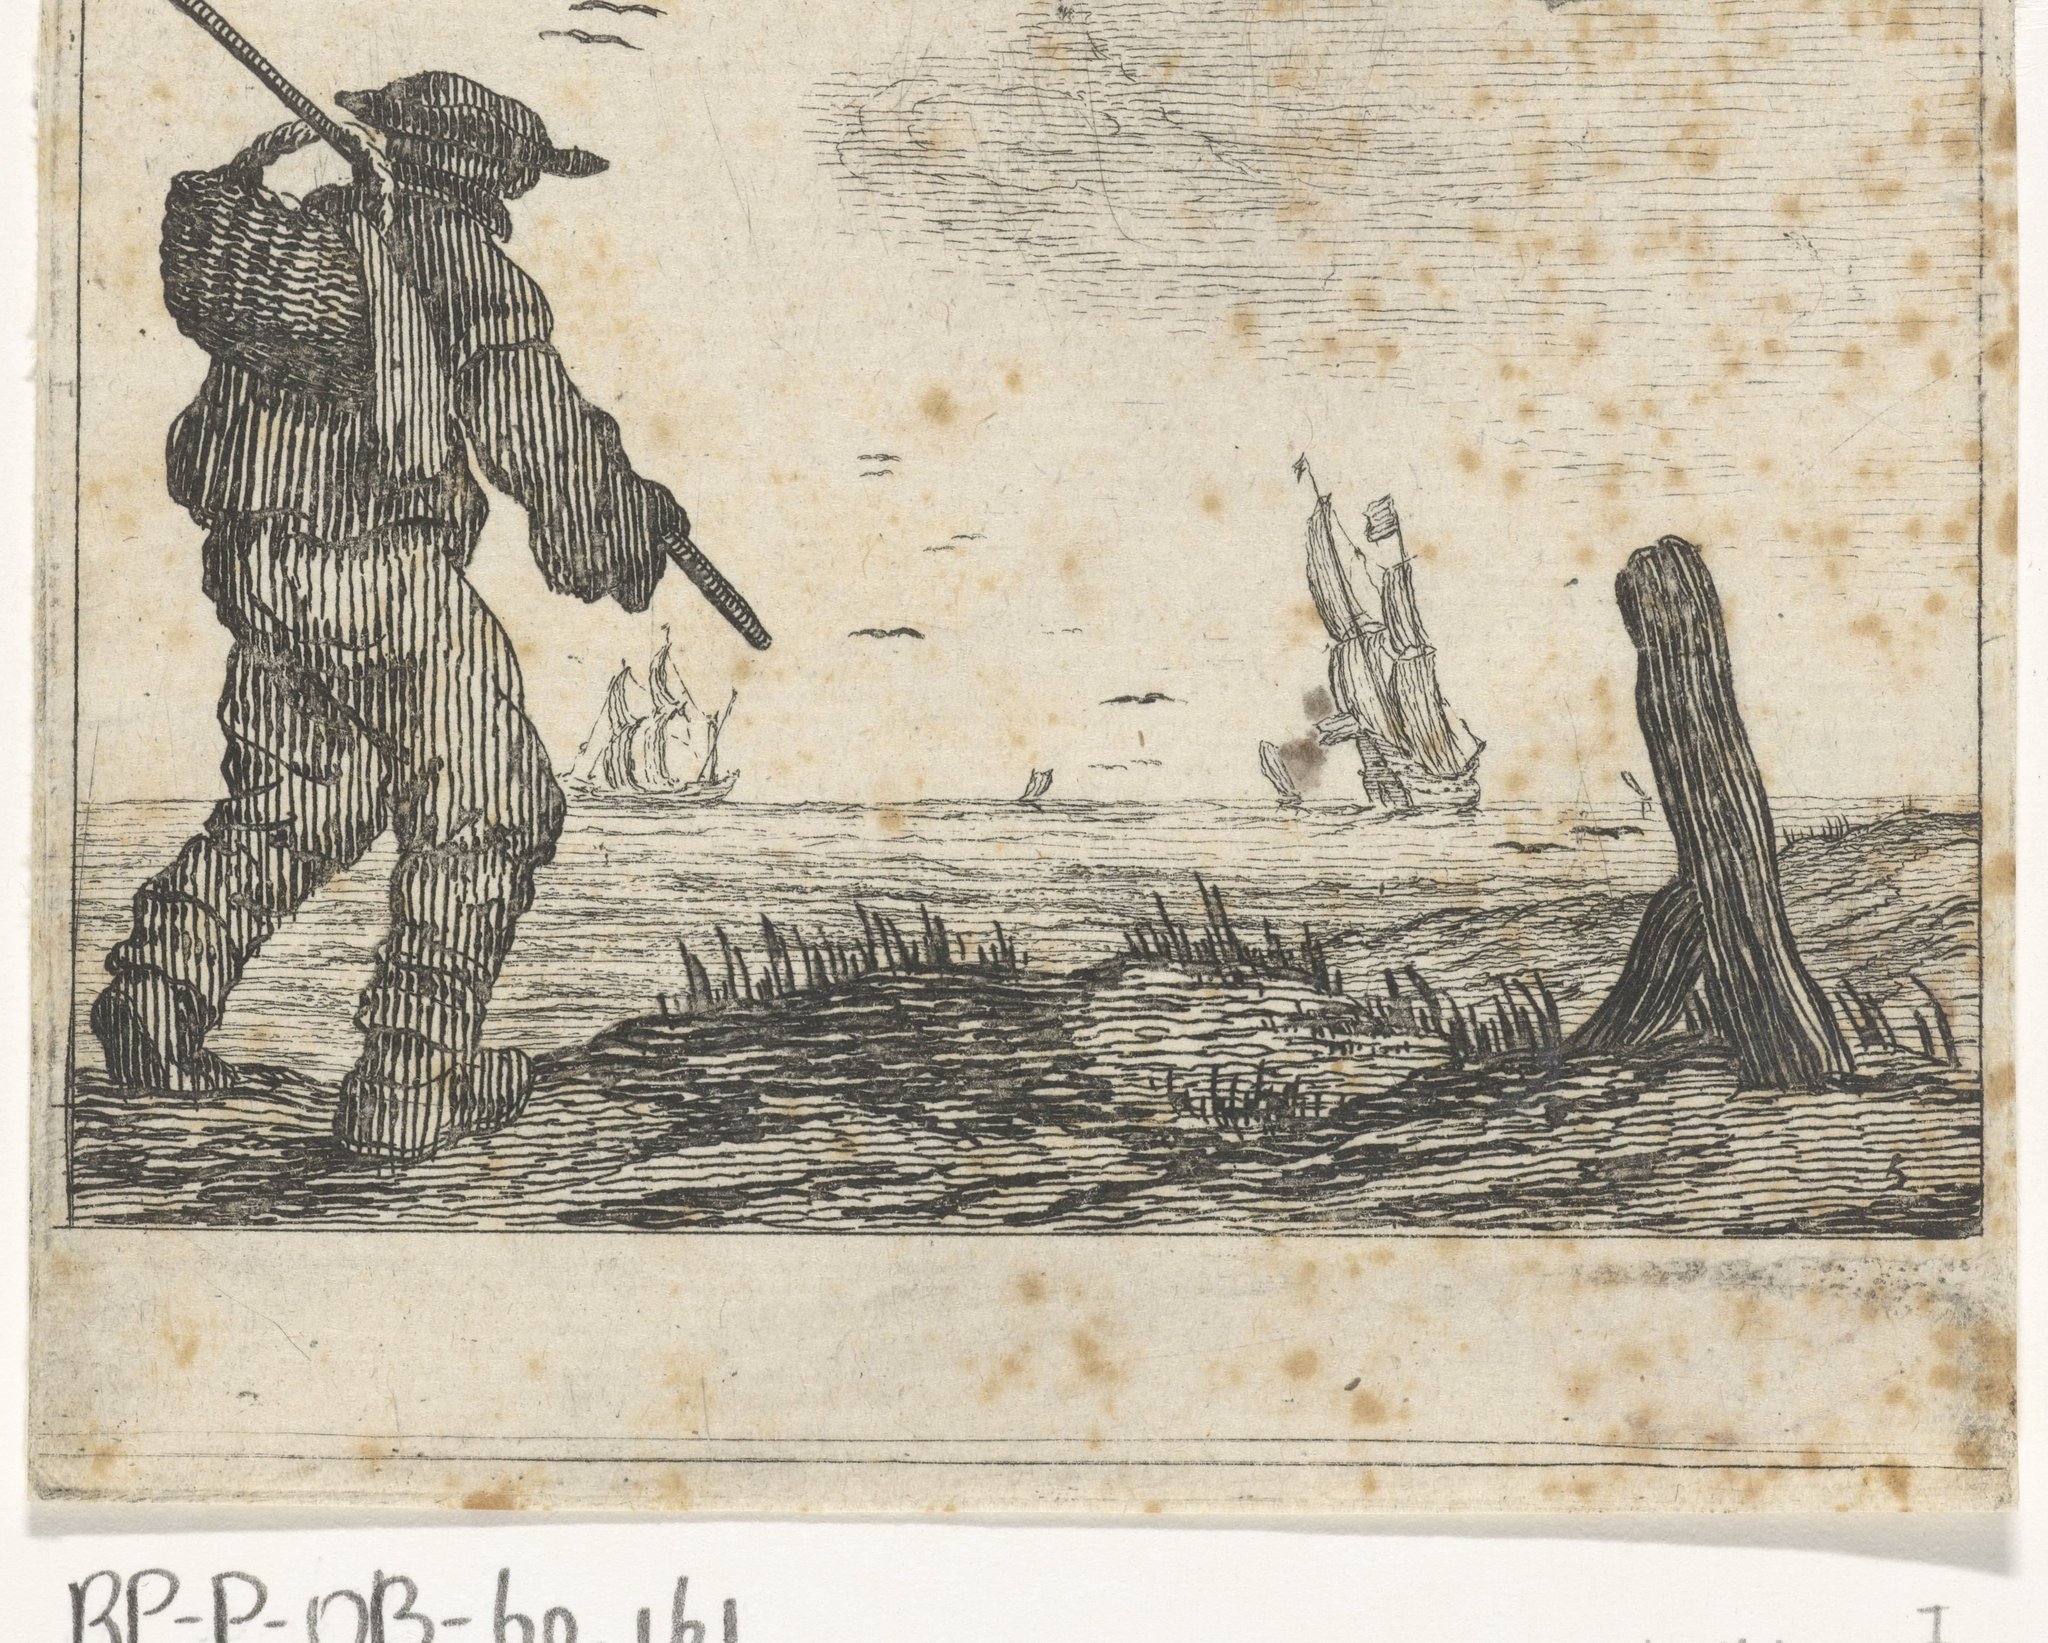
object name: print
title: Duinlandschap met een man, met een mand op de schouder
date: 1618-1645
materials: paper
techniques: etching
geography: northern netherlands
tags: dune coast, carrying something in basket, bag, rucksack, etc.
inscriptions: collector's mark: Lugt 240